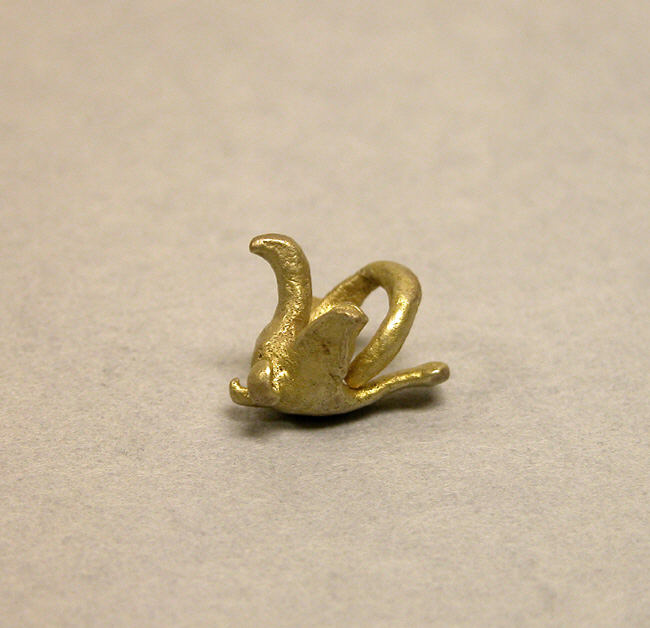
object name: pendant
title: Brahma's Goose Pendant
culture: indonesian, central java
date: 701-1200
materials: gold